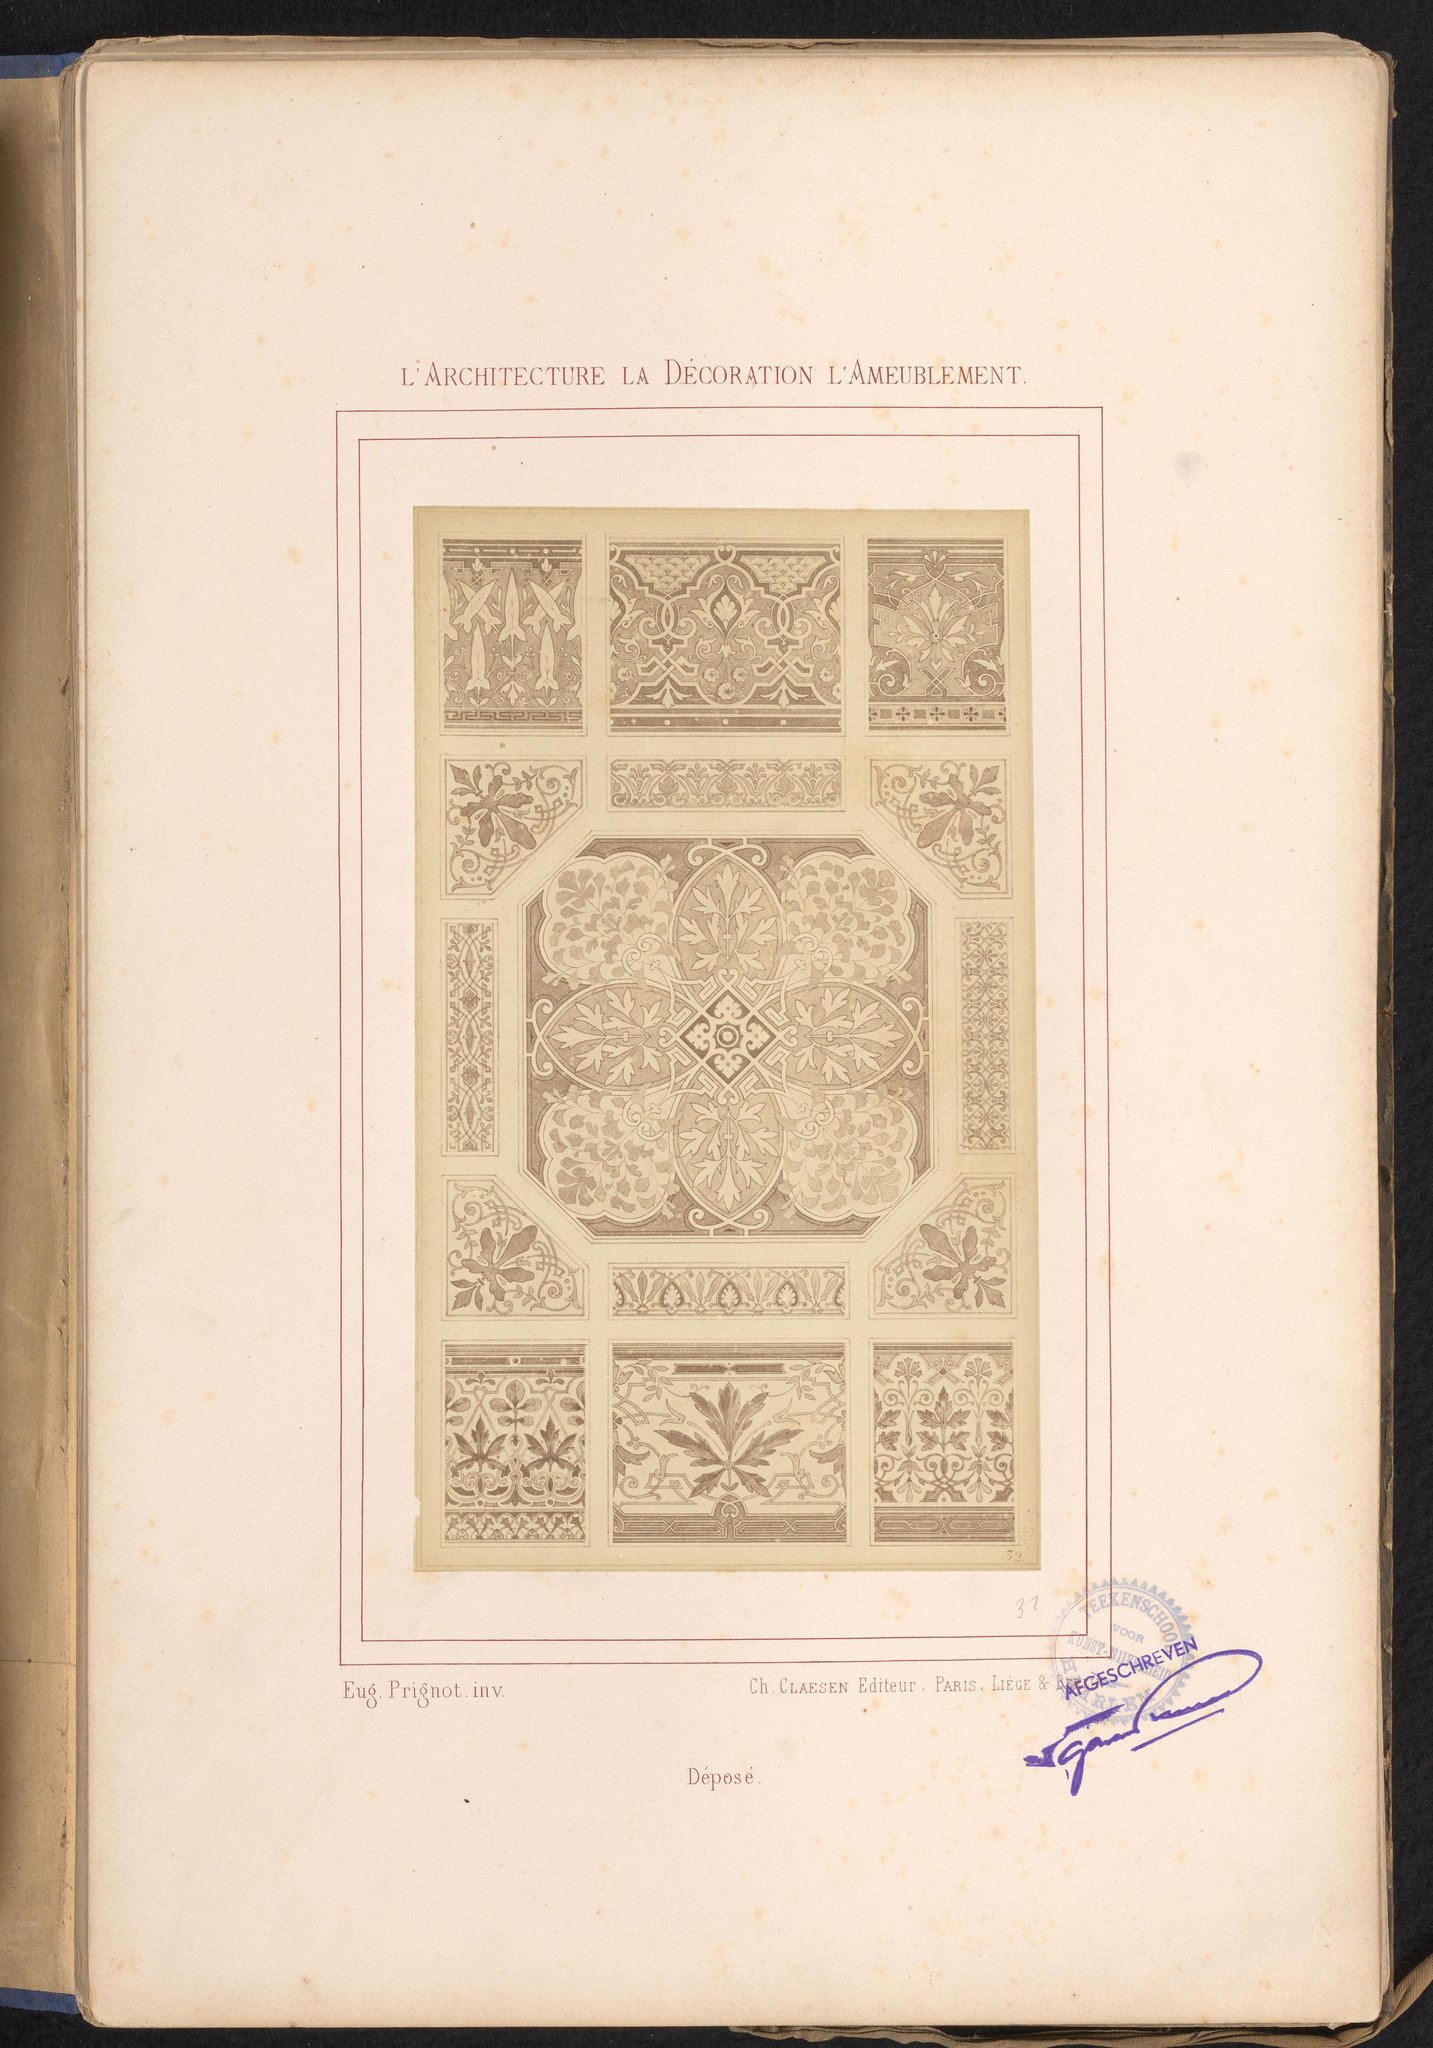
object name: reproduction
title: L'Architecture la Décoration l'Ameublement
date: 1873-1880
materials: cardboard, paper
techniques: albumen print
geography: liège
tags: ornament derived from plant forms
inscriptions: stamp: ‘AFGESCHREVEN/ [...]’, inscription: ‘Déposé’, number: ‘32’, stamp: ‘TEEKENSCHOOL/ VOOR/ KUNST-NIJVERHEID/ HAARLEM’, inscription: ‘Eug. Prignot. inv.’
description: Deze foto maakt deel uit van een omslag met 61 foto's op 61 bladen.